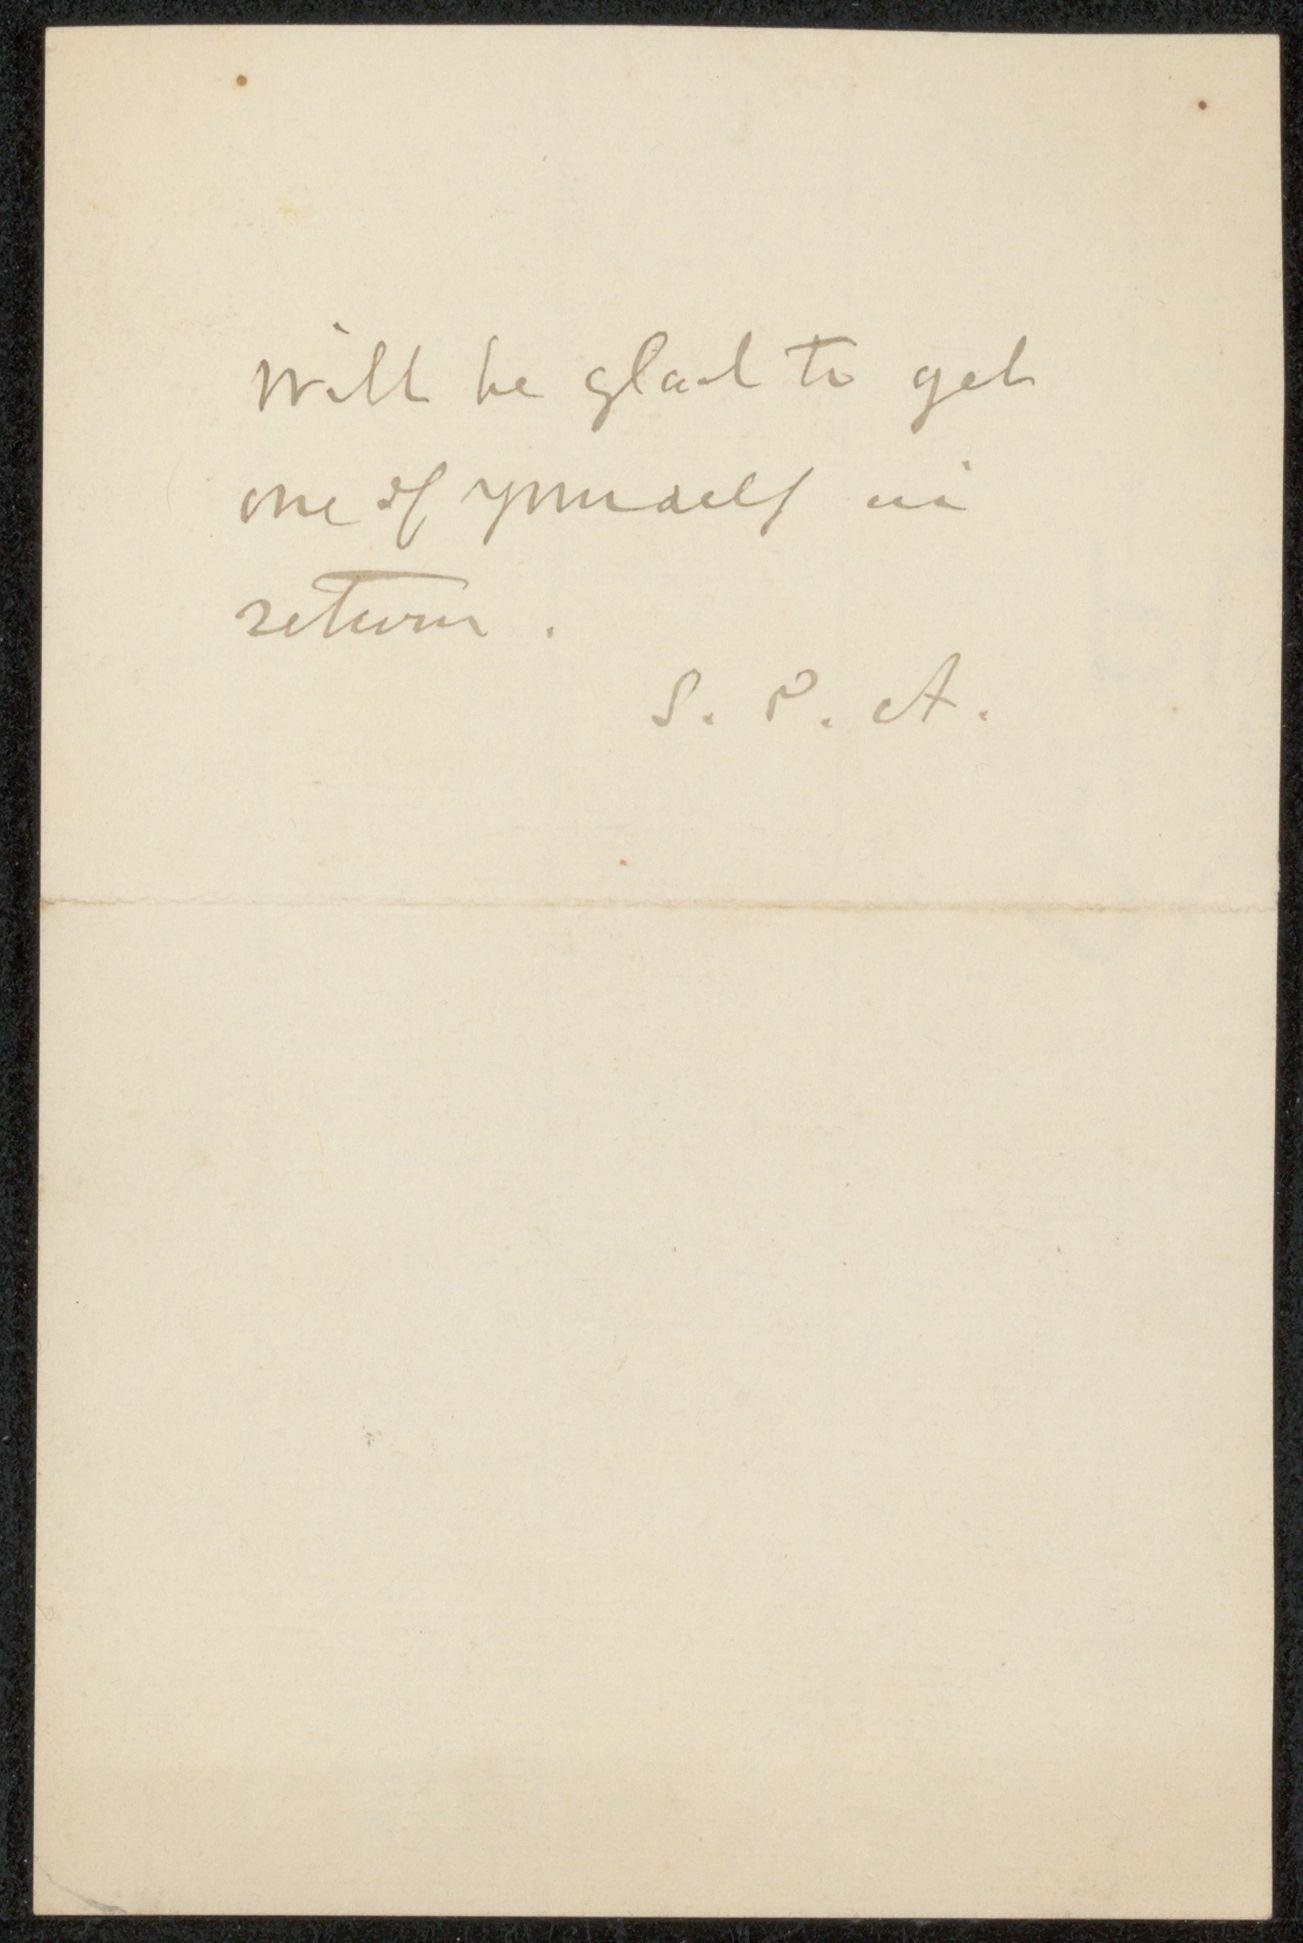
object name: letter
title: Brief aan Philip Zilcken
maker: samuel putnam avery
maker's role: verzamelaar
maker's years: 1822-1904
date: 1832-1904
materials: ink, paper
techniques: pen, writing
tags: the hague, painter, draughtsman, philip zilcken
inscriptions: collector's mark: ‘RPK’